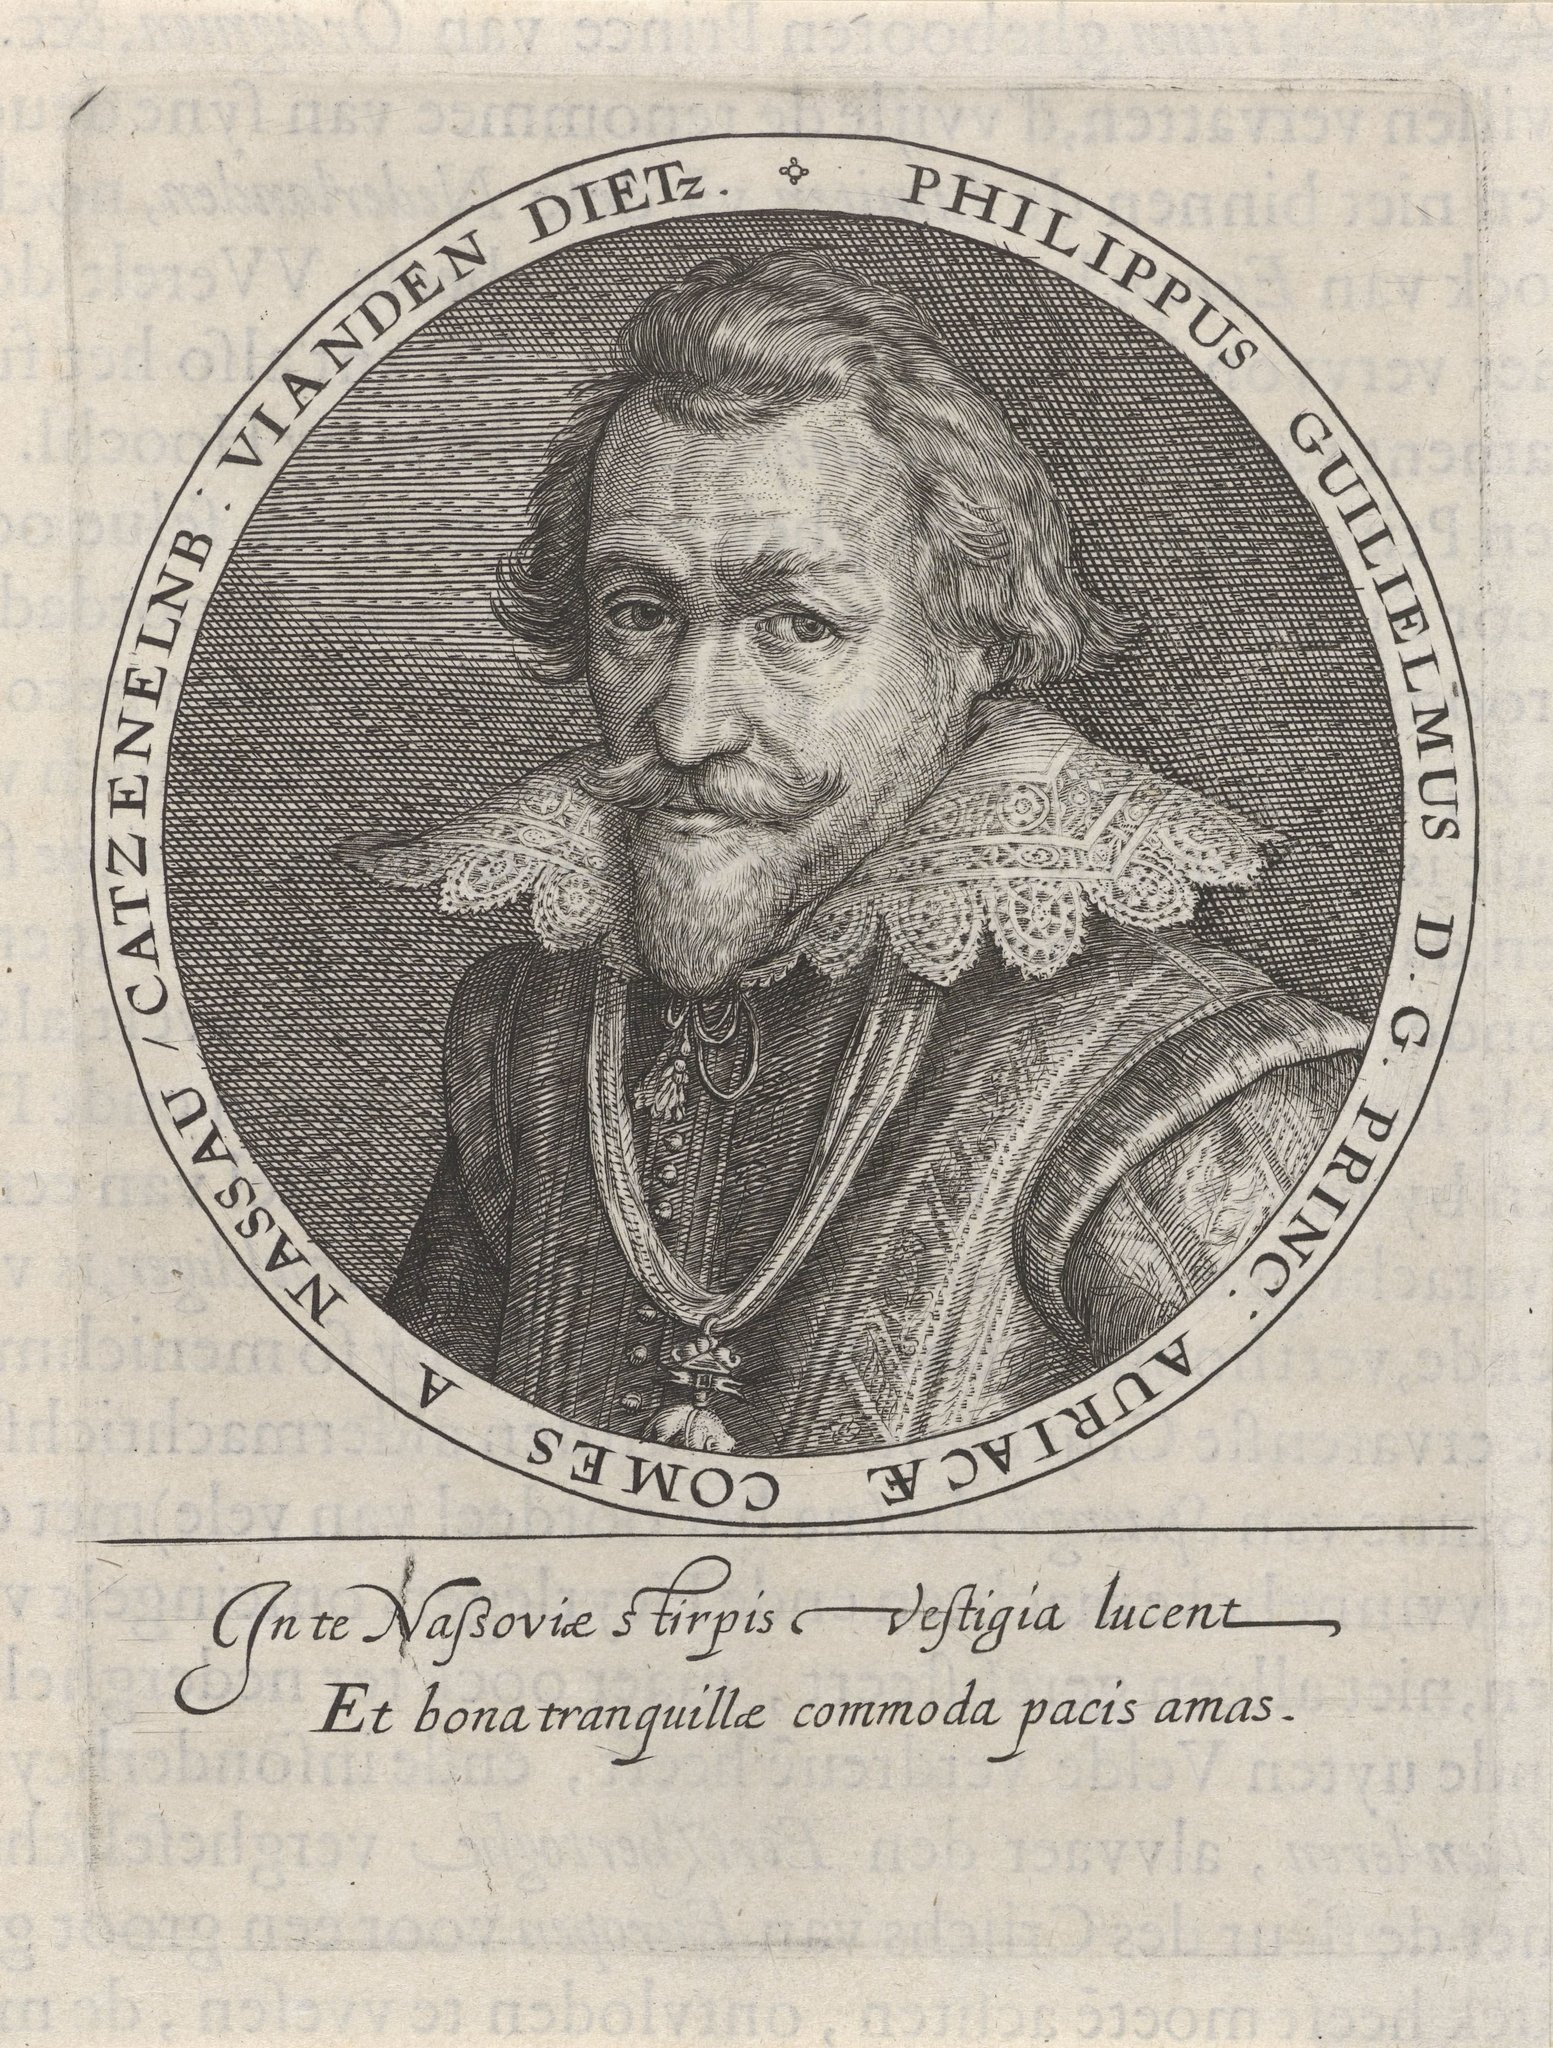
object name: print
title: Portret van Filips Willem, prins van Oranje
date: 1615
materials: paper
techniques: engraving, etching, letterpress printing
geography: utrecht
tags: filips willem (prins van oranje), knighthood order of the golden fleece - insignia of a knighthood order, e.g.: badge, chain (with name of order)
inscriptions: collector's mark: Lugt 963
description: De hier vermelde titel verwijst naar de hoogst verkregen titel van de geportretteerde, niet per se naar de titel die de geportretteerde op deze voorstelling draagt. Prent uit: Buchelius, Arnoldus. Nassovischen Oraignen-boom, daer by ghevoecht, de conterfeytsels der voornaemster helden. = Malus Aurantius Nassovicus. Utrecht: Salomon de Roy, 1615.